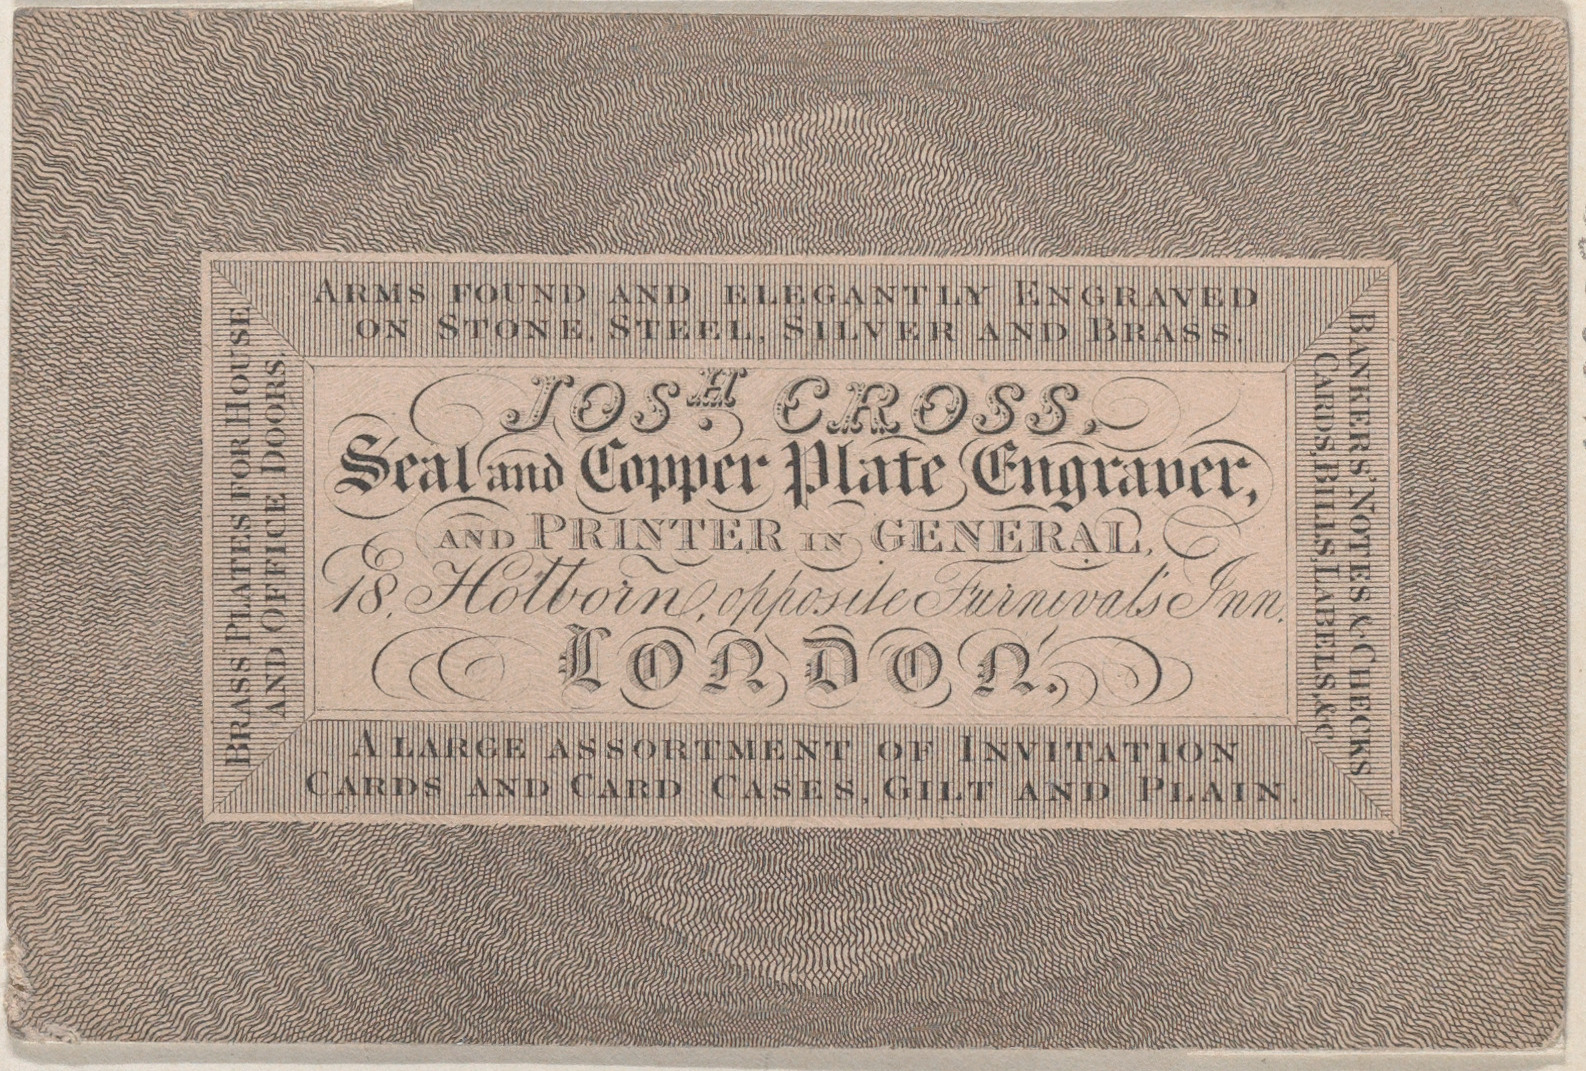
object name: print, trade card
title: Trade Card for Josh Cross, Seal and Copper Plate Engraver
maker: anonymous, british, 19th century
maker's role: artist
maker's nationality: british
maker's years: 1800-1900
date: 1801-1900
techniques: engraving